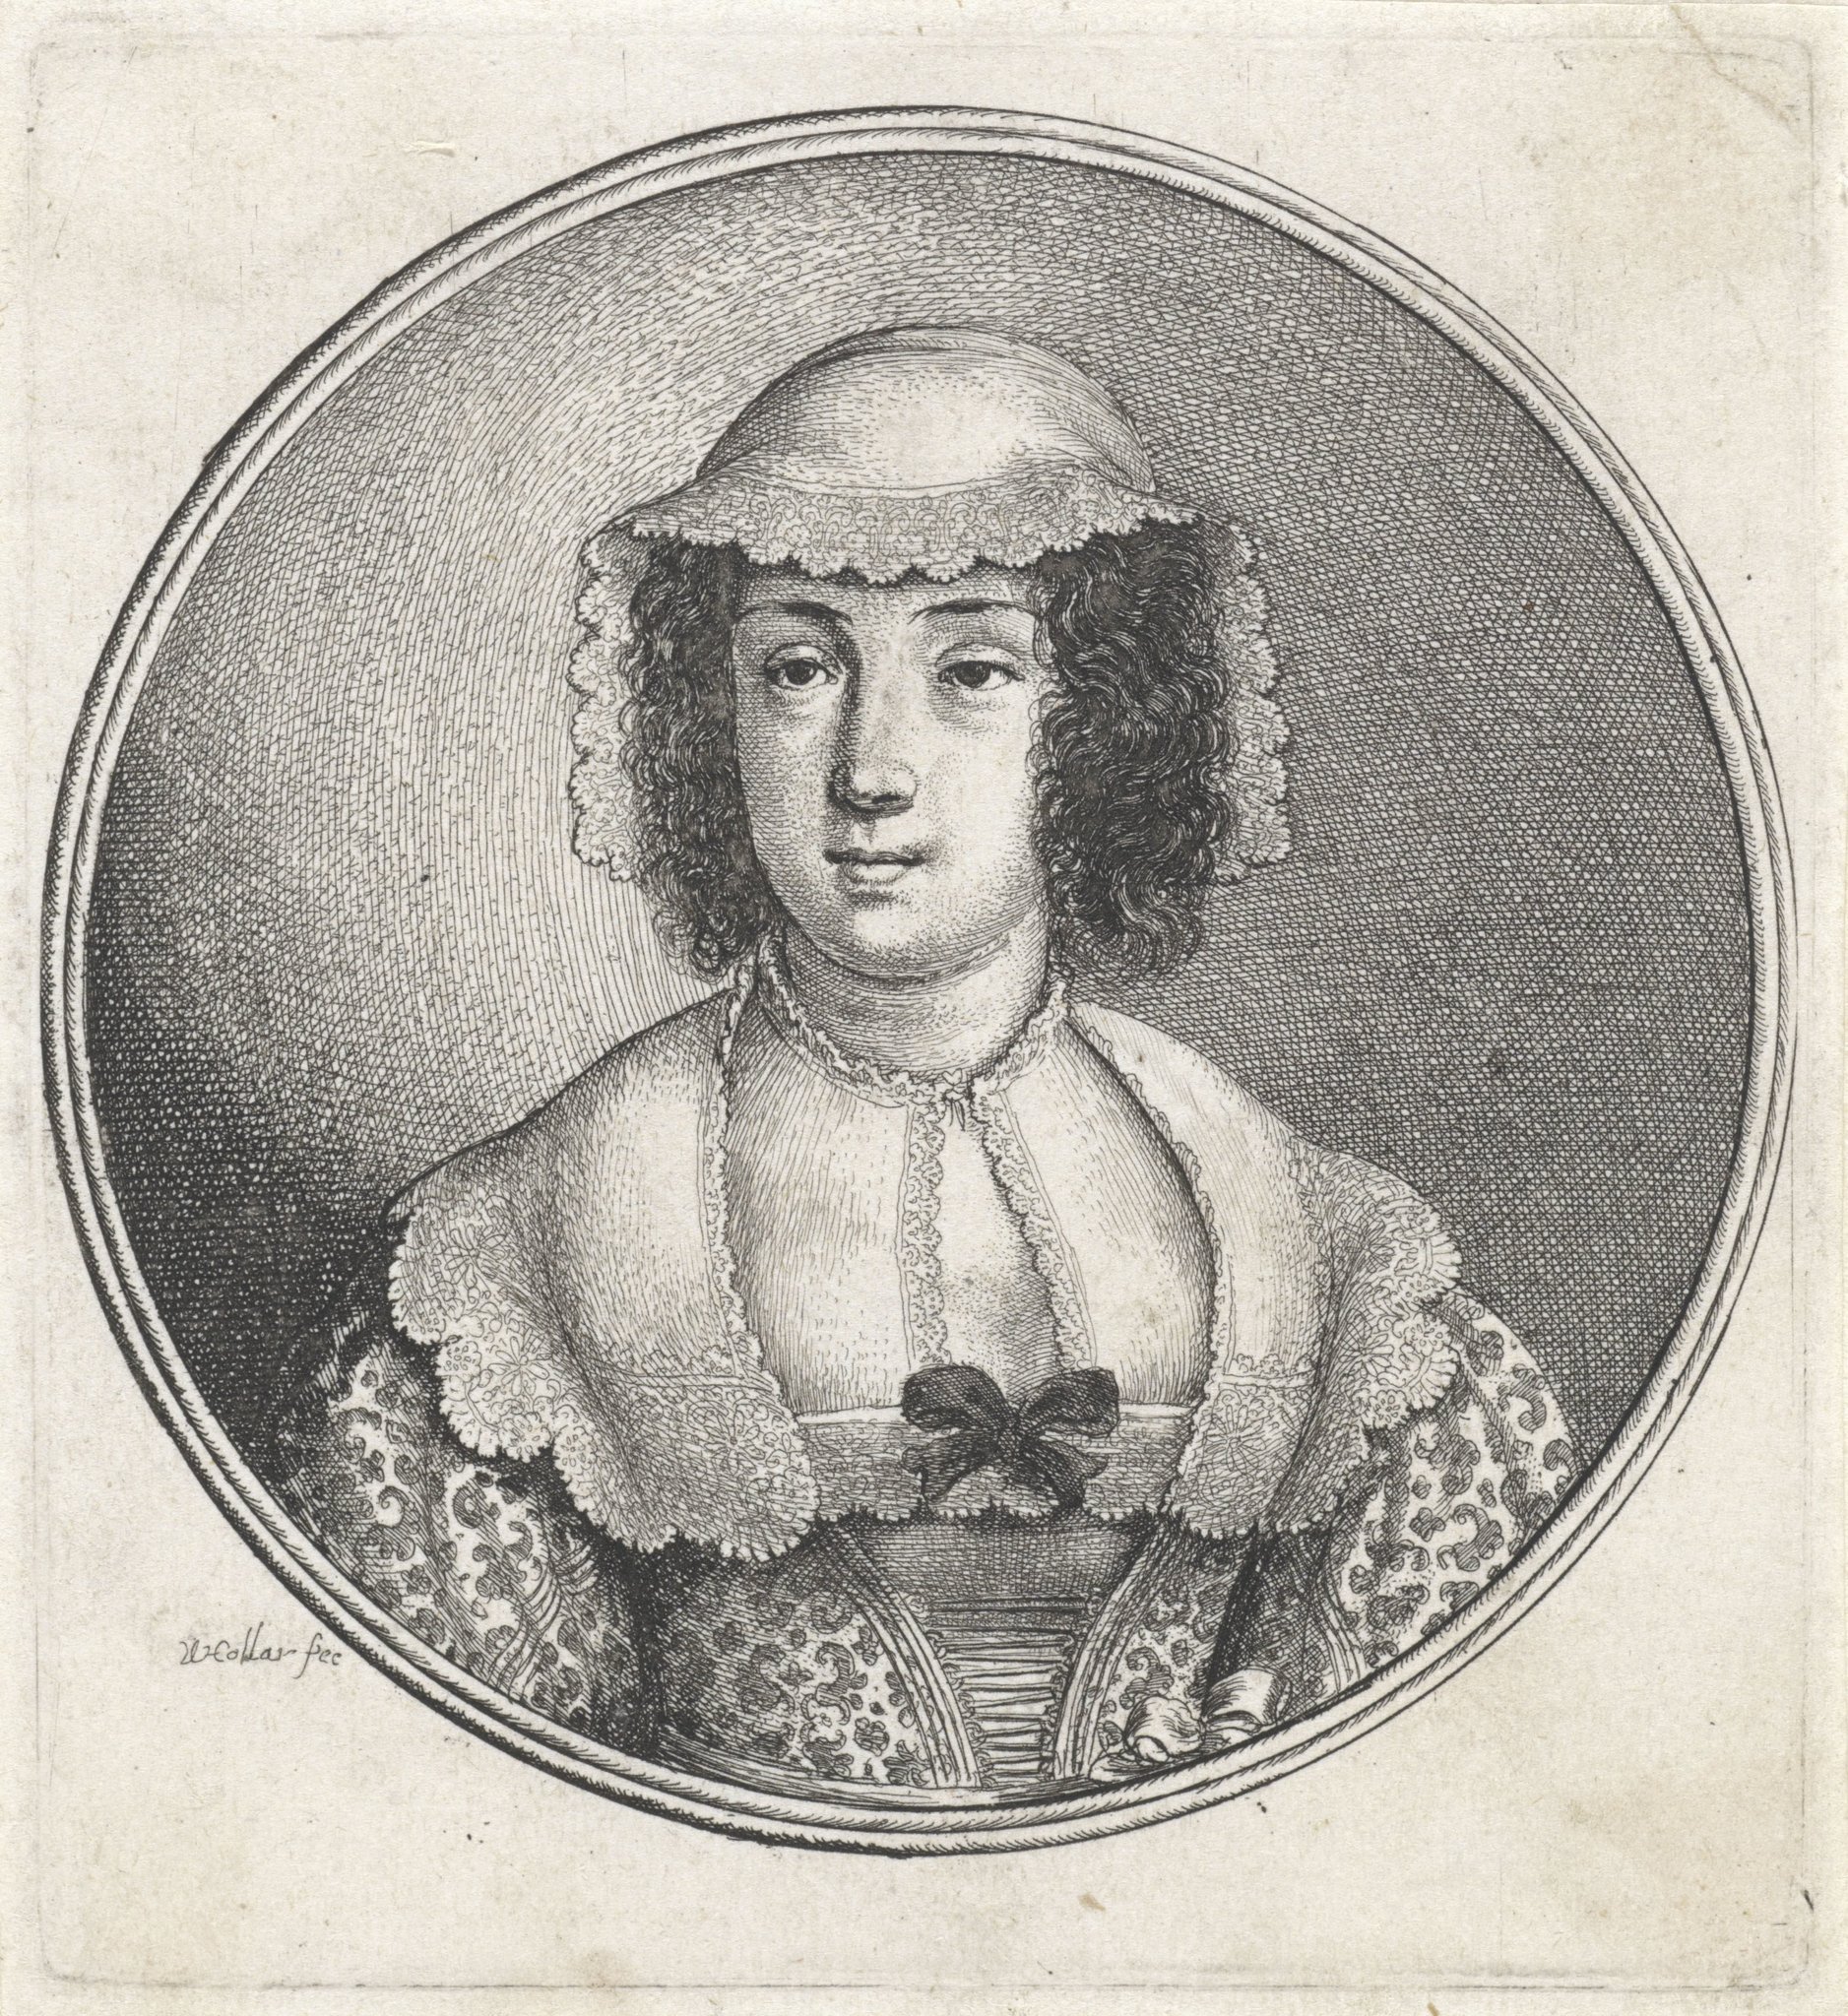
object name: print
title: Vrouw met kanten hoofdkapje en een strik op het decolleté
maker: wenceslaus hollar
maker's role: draughtsman, print maker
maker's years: 1607-1677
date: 1644-1647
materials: paper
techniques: etching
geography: antwerp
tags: anonymous historical person portrayed alone - bb - woman, head-gear: cap (+ women's clothes), neck-gear: collar (+ women's clothes), bow (ornamental part of clothing)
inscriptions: collector's mark: Lugt 654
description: De prent maakt deel uit van een 23-delige serie met verschillende vrouwenbusten in ronde lijsten.